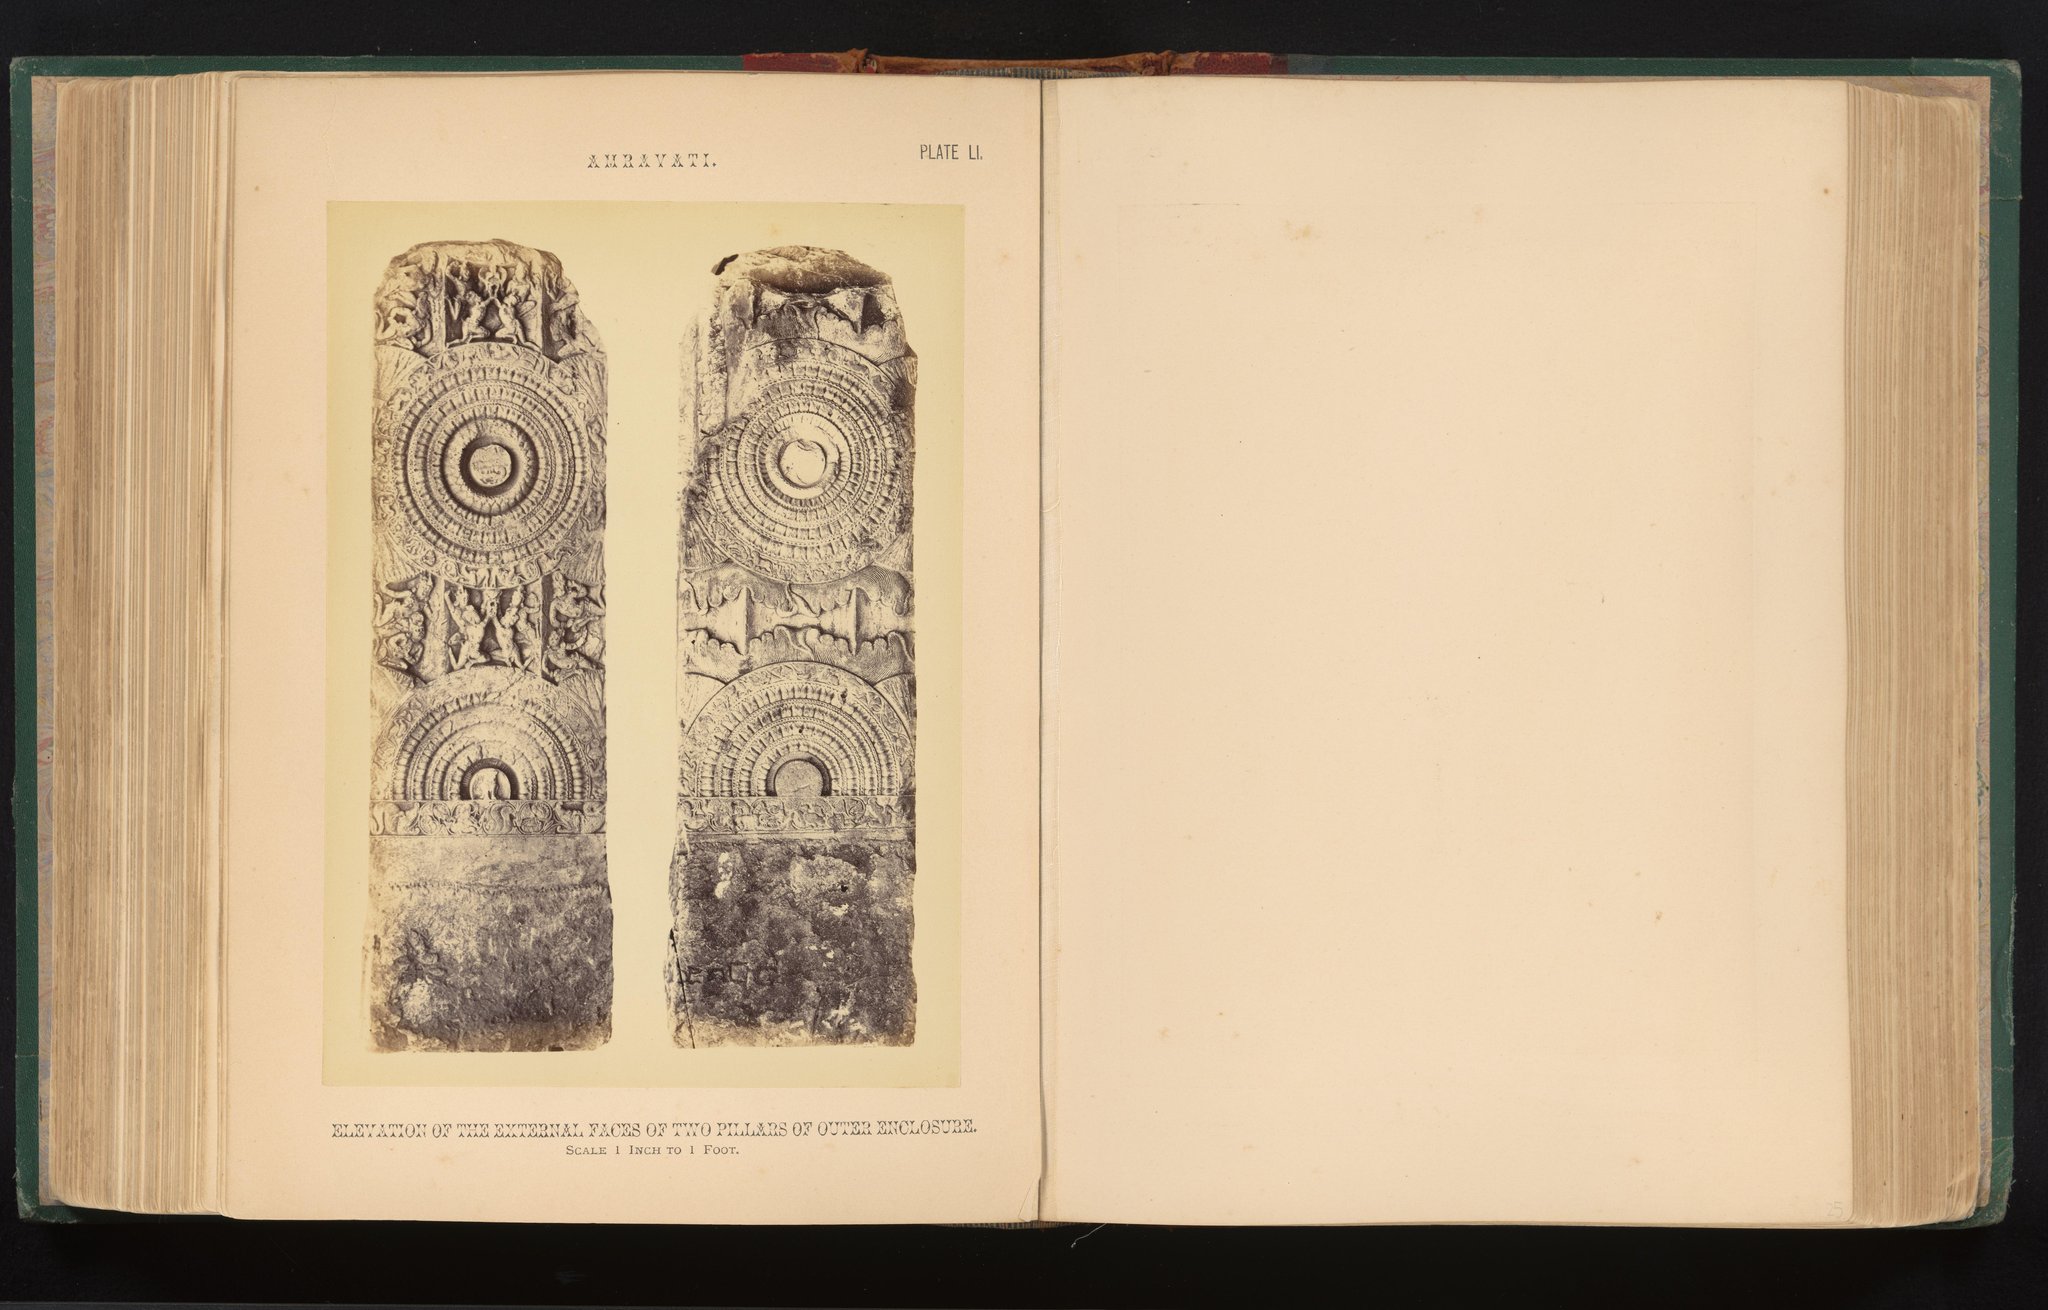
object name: page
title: Pillars with relief, Amaravati, Andhra Pradesh, India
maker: william h. griggs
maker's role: printer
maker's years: 1832-1911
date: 1863-1868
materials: photographic support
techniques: albumen print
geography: amaravati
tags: hinduism, buddhism, jainism, column, pillar ~ architecture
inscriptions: inscription: ‘AMRAVATI. PLATE LI.’, inscription: ‘ELEVATION OF THE EXTERNAL FACES OF TWO PILLARS OF OUTER ENCLOSURE./ SCALE 1 INCH TO 1 FOOT.’